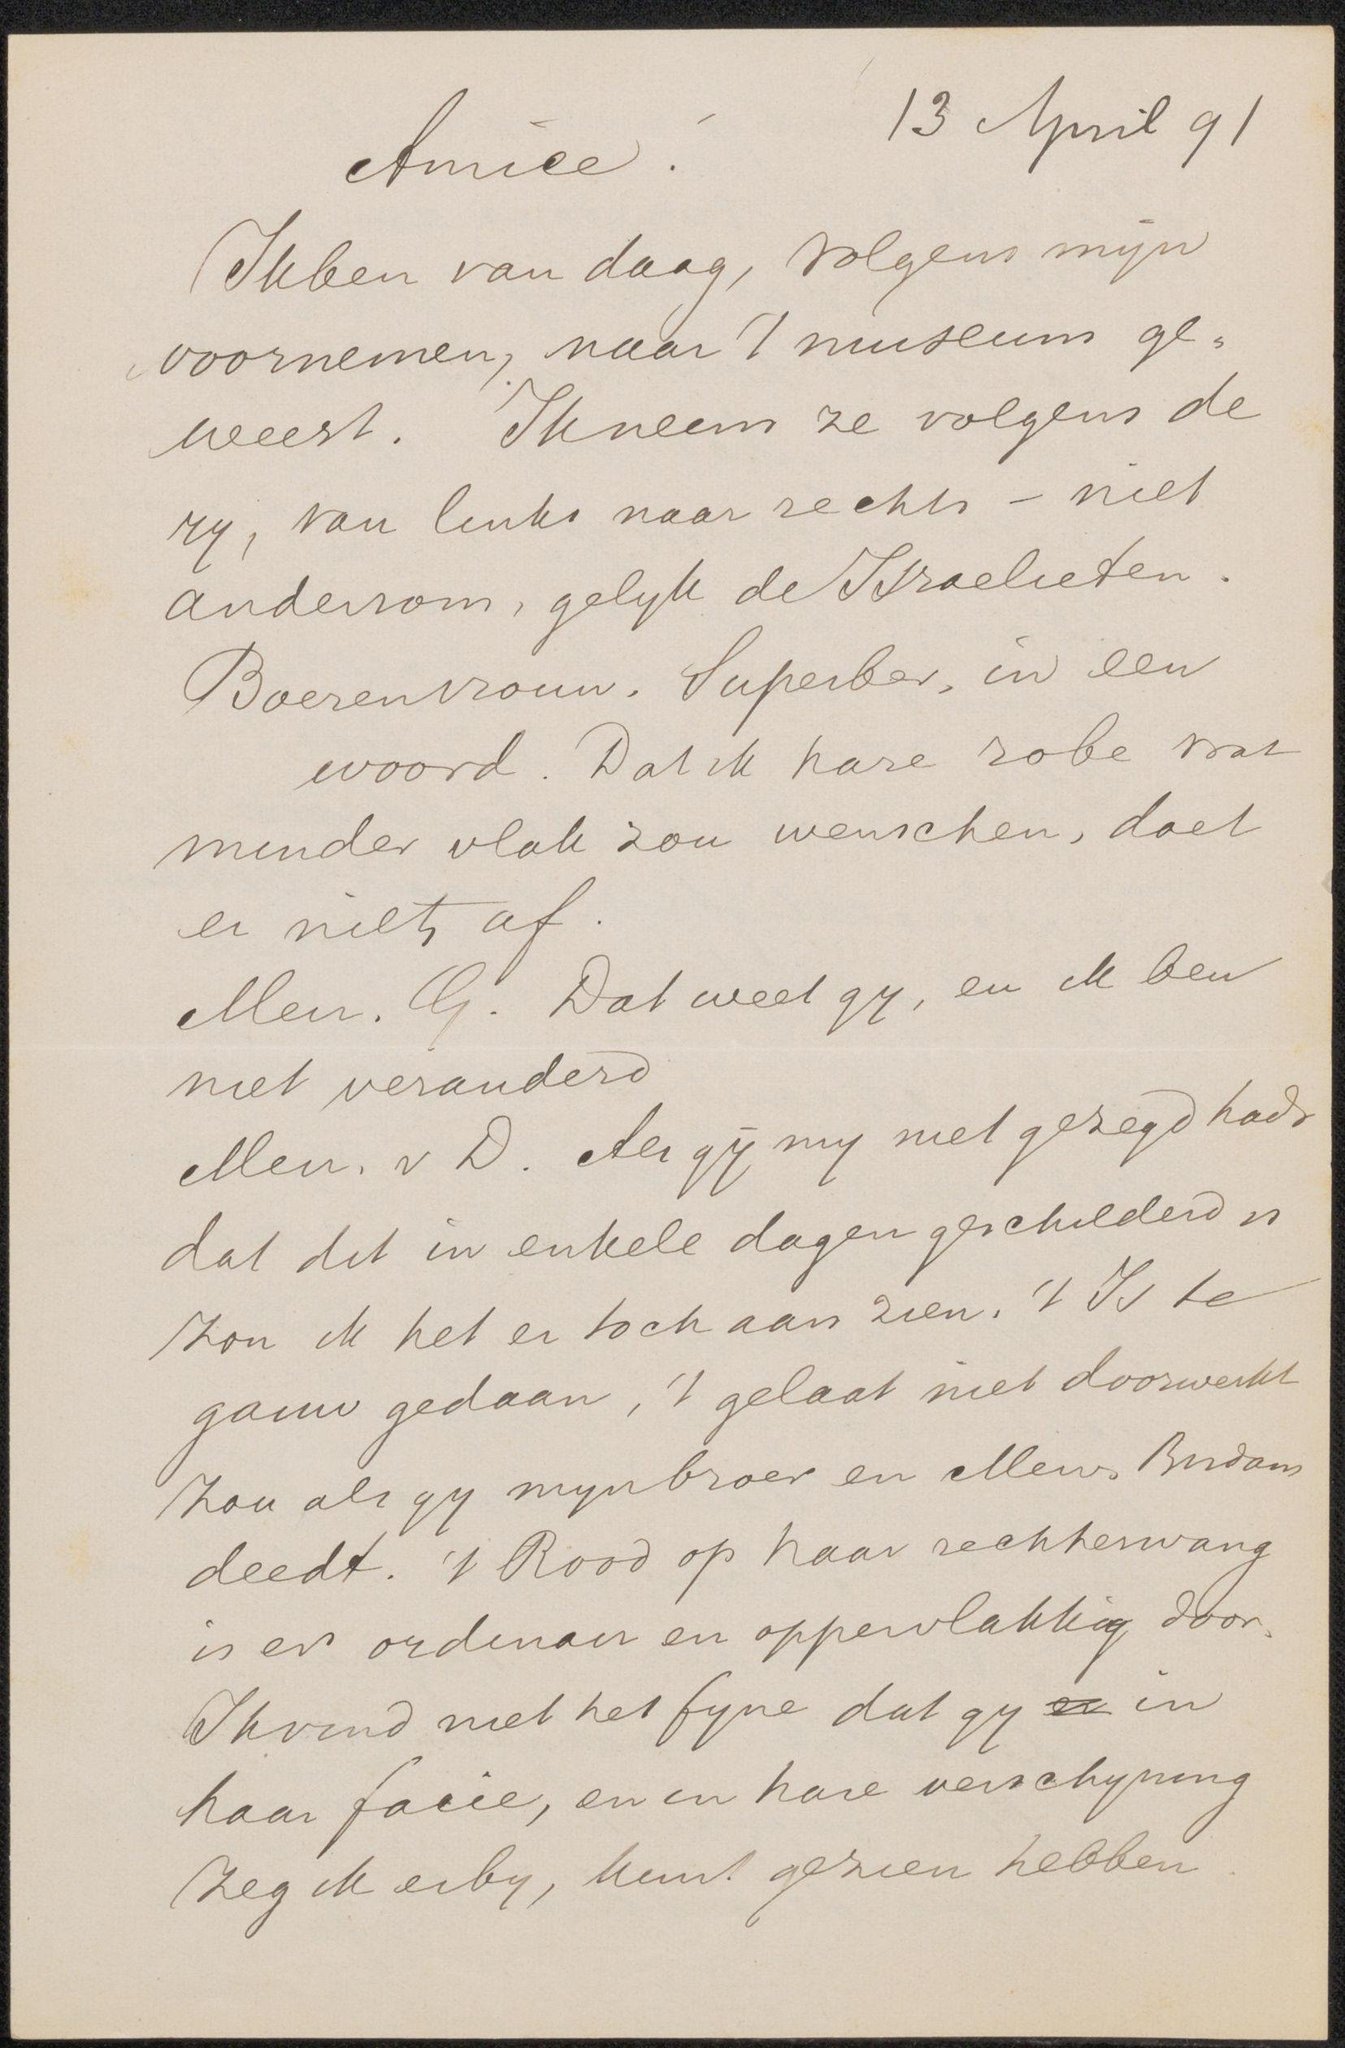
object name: letter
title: Brief aan Jan Veth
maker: martinus cornelis lebret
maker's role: verzamelaar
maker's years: 1833-1894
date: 1891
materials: ink, paper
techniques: pen, writing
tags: daubigny, dordrecht, designer, jan veth, paris, painter, draughtsman, camille corot, narcisse virgile diaz de la peña, utrecht, print maker, etha fles, allard pierson, historical persons (portraits and scenes from the life)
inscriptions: collector's mark: ‘RPK’